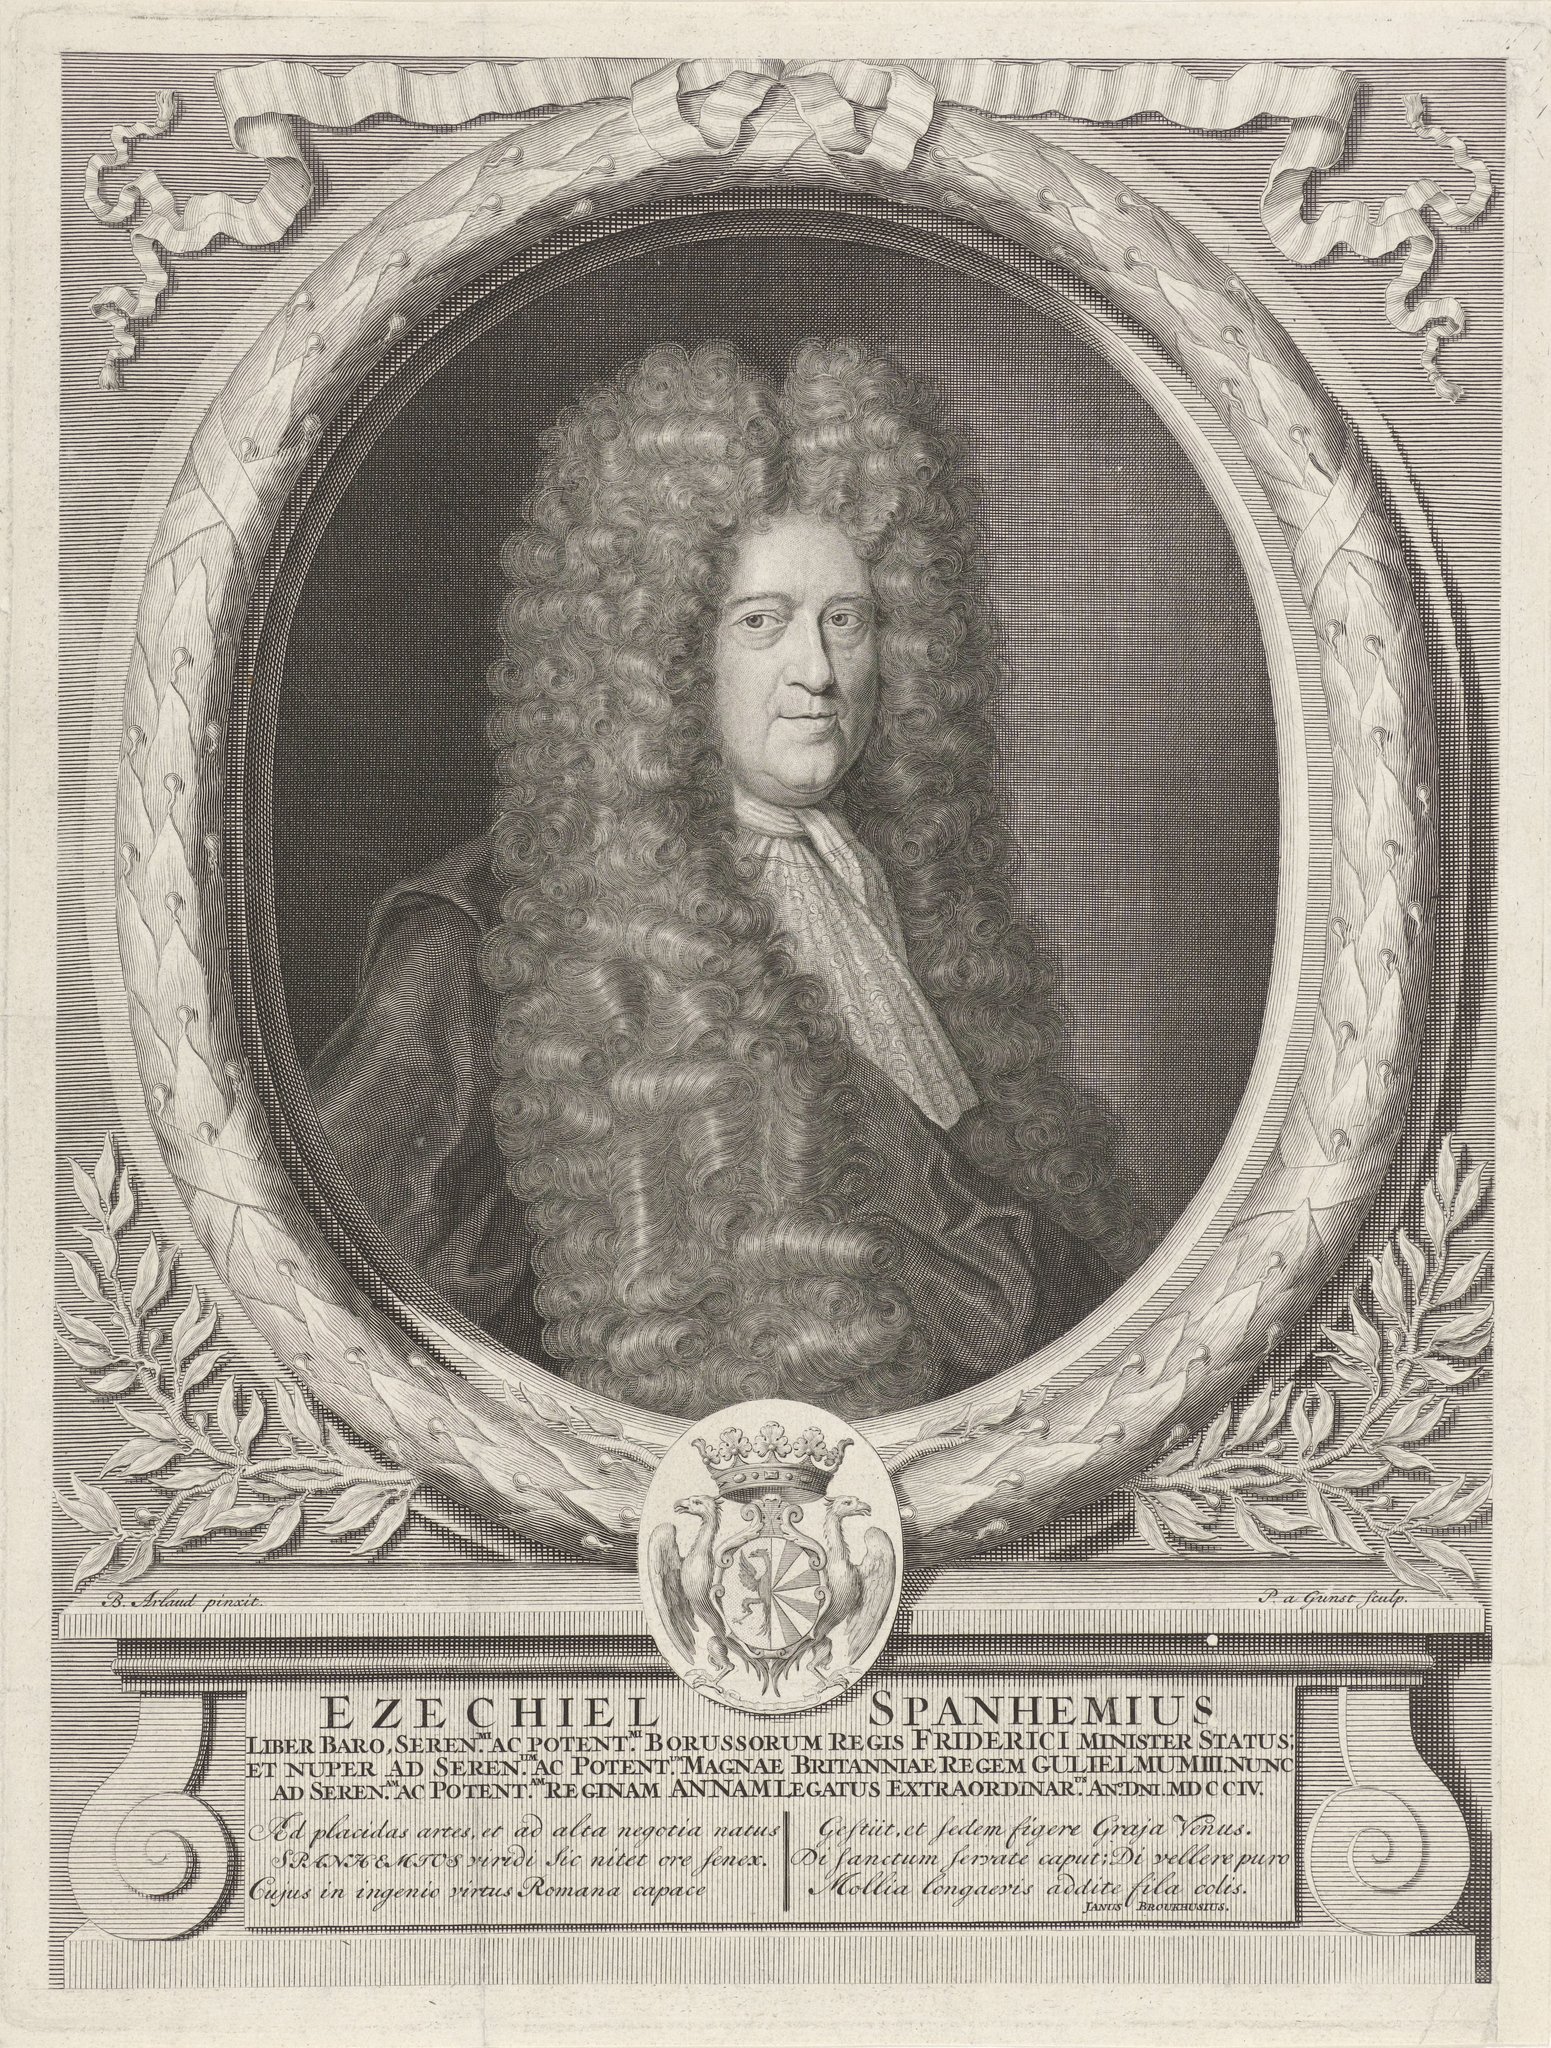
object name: print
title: Portret van Ezechiel Spanheim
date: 1679-1731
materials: paper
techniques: engraving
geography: amsterdam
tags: genève (kanton), ezechiel spanheim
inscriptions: collector's mark: Lugt 2228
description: Ezechiel Spanheim, Zwitserse geleerde en hoogleraar retorica in Genève. De prent heeft een Latijns onderschrift.